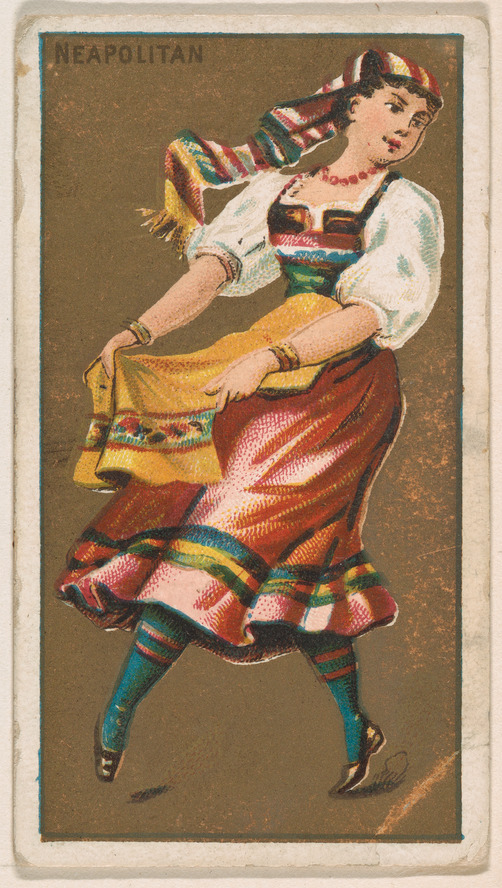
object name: print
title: Neapolitan, from National Dances (N225, Type 1) issued by Kinney Bros.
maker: kinney brothers tobacco company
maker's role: publisher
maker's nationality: american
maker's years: 1869-2011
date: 1889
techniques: color lithograph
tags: dance,women,dancing